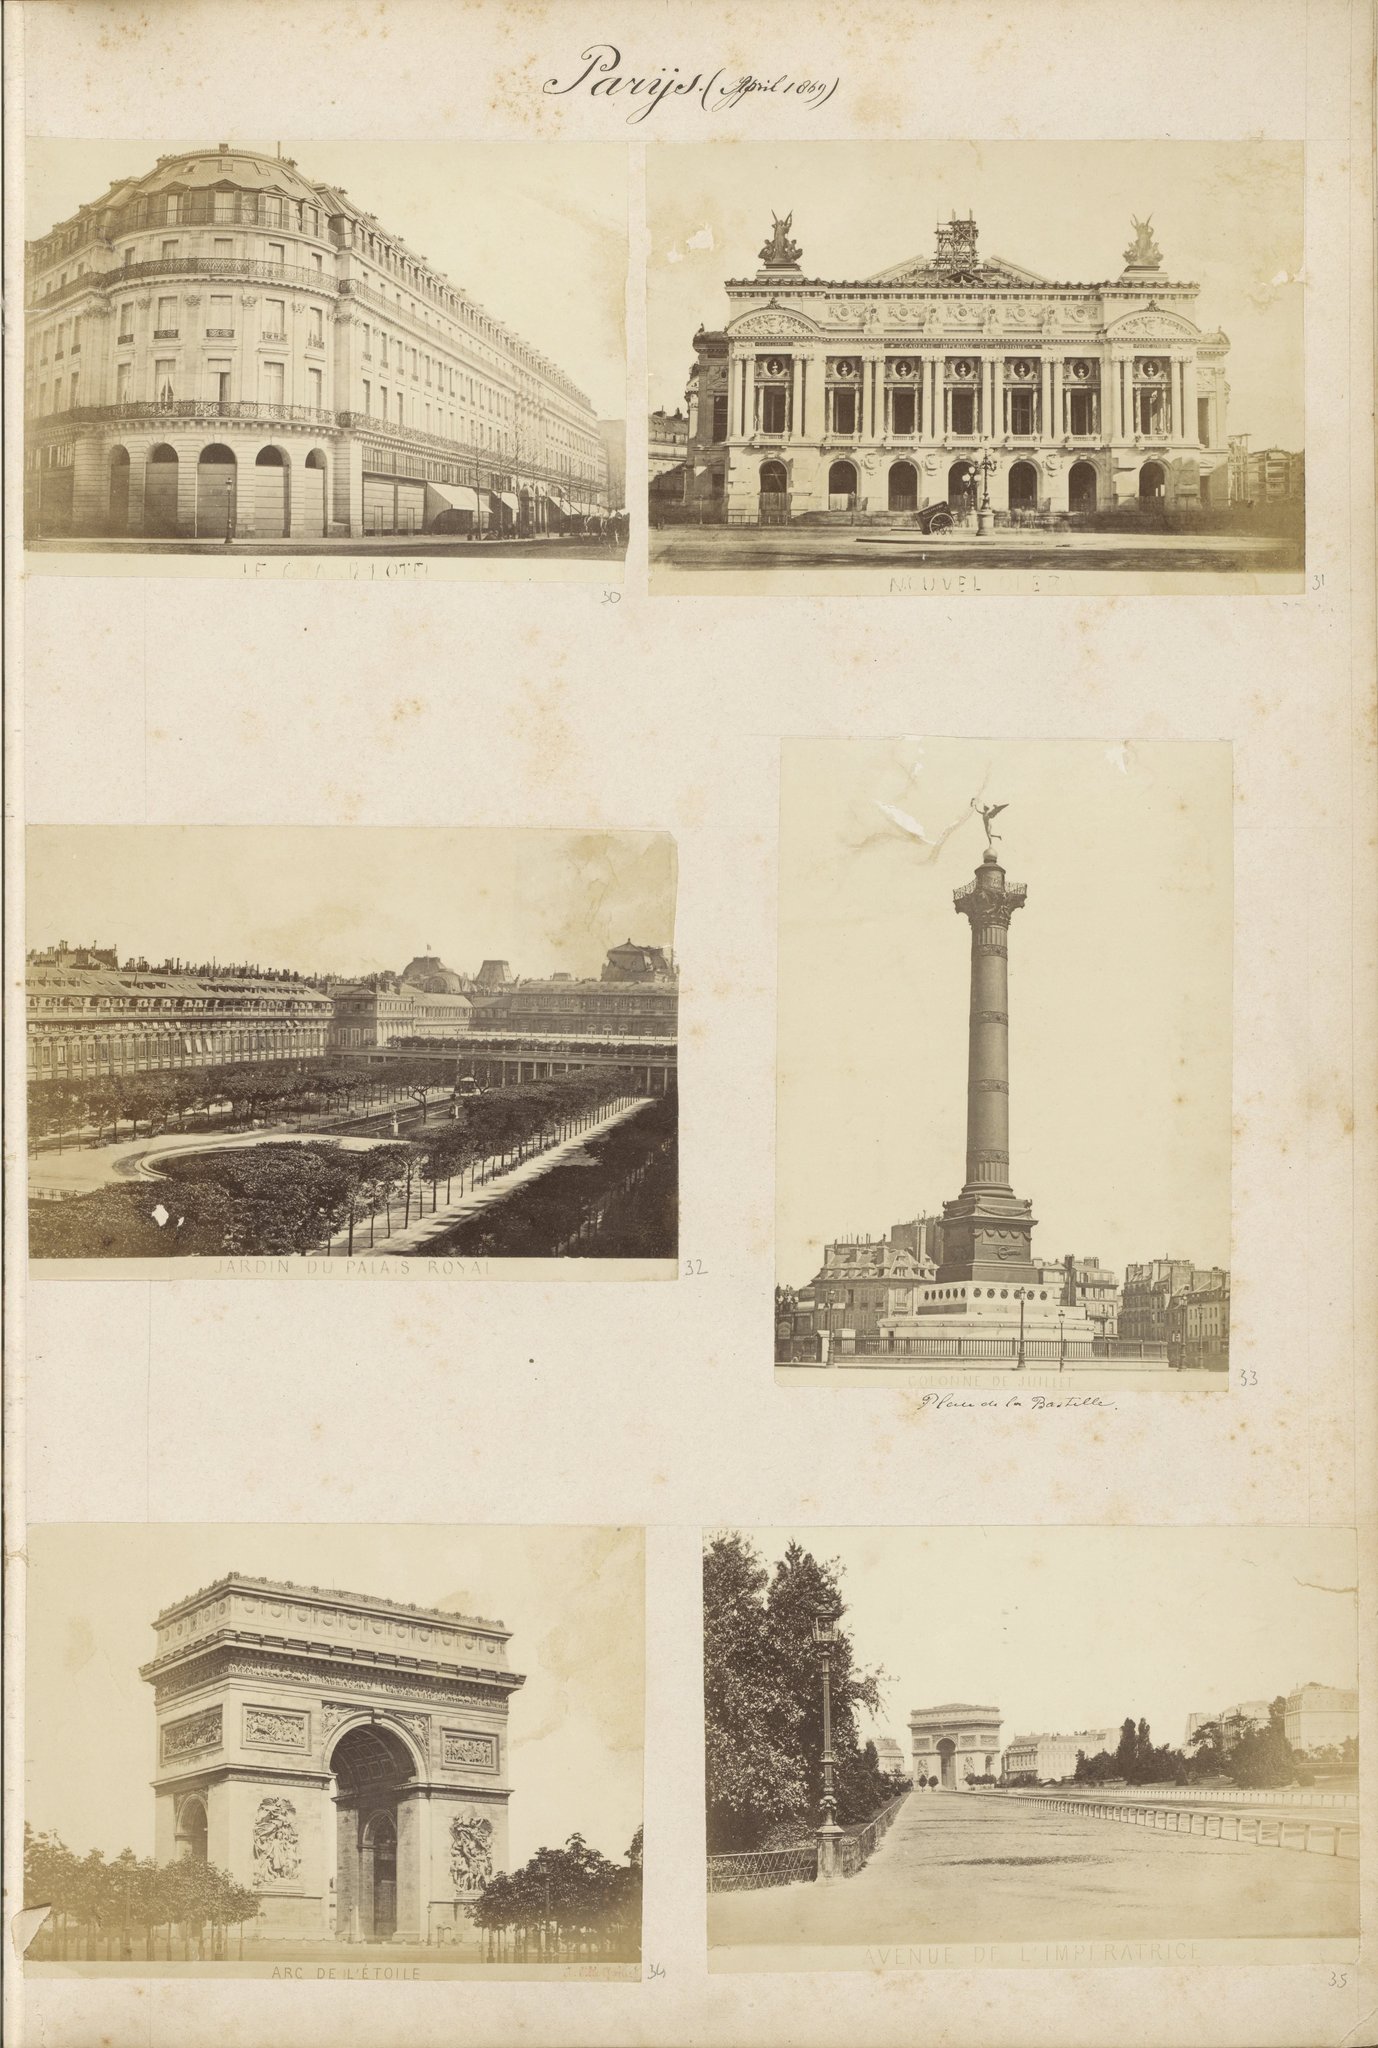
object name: photograph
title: Gezicht op de tuinen van het Palais Royal in Parijs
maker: Anonymous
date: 1804-1869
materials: paper, photographic support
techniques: albumen print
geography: paris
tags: public gardens, park (+ city(-scape) with figures, staffage), paris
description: Onderdeel van Fotoalbum van Robert Daniel Crommelin (1841-1907).